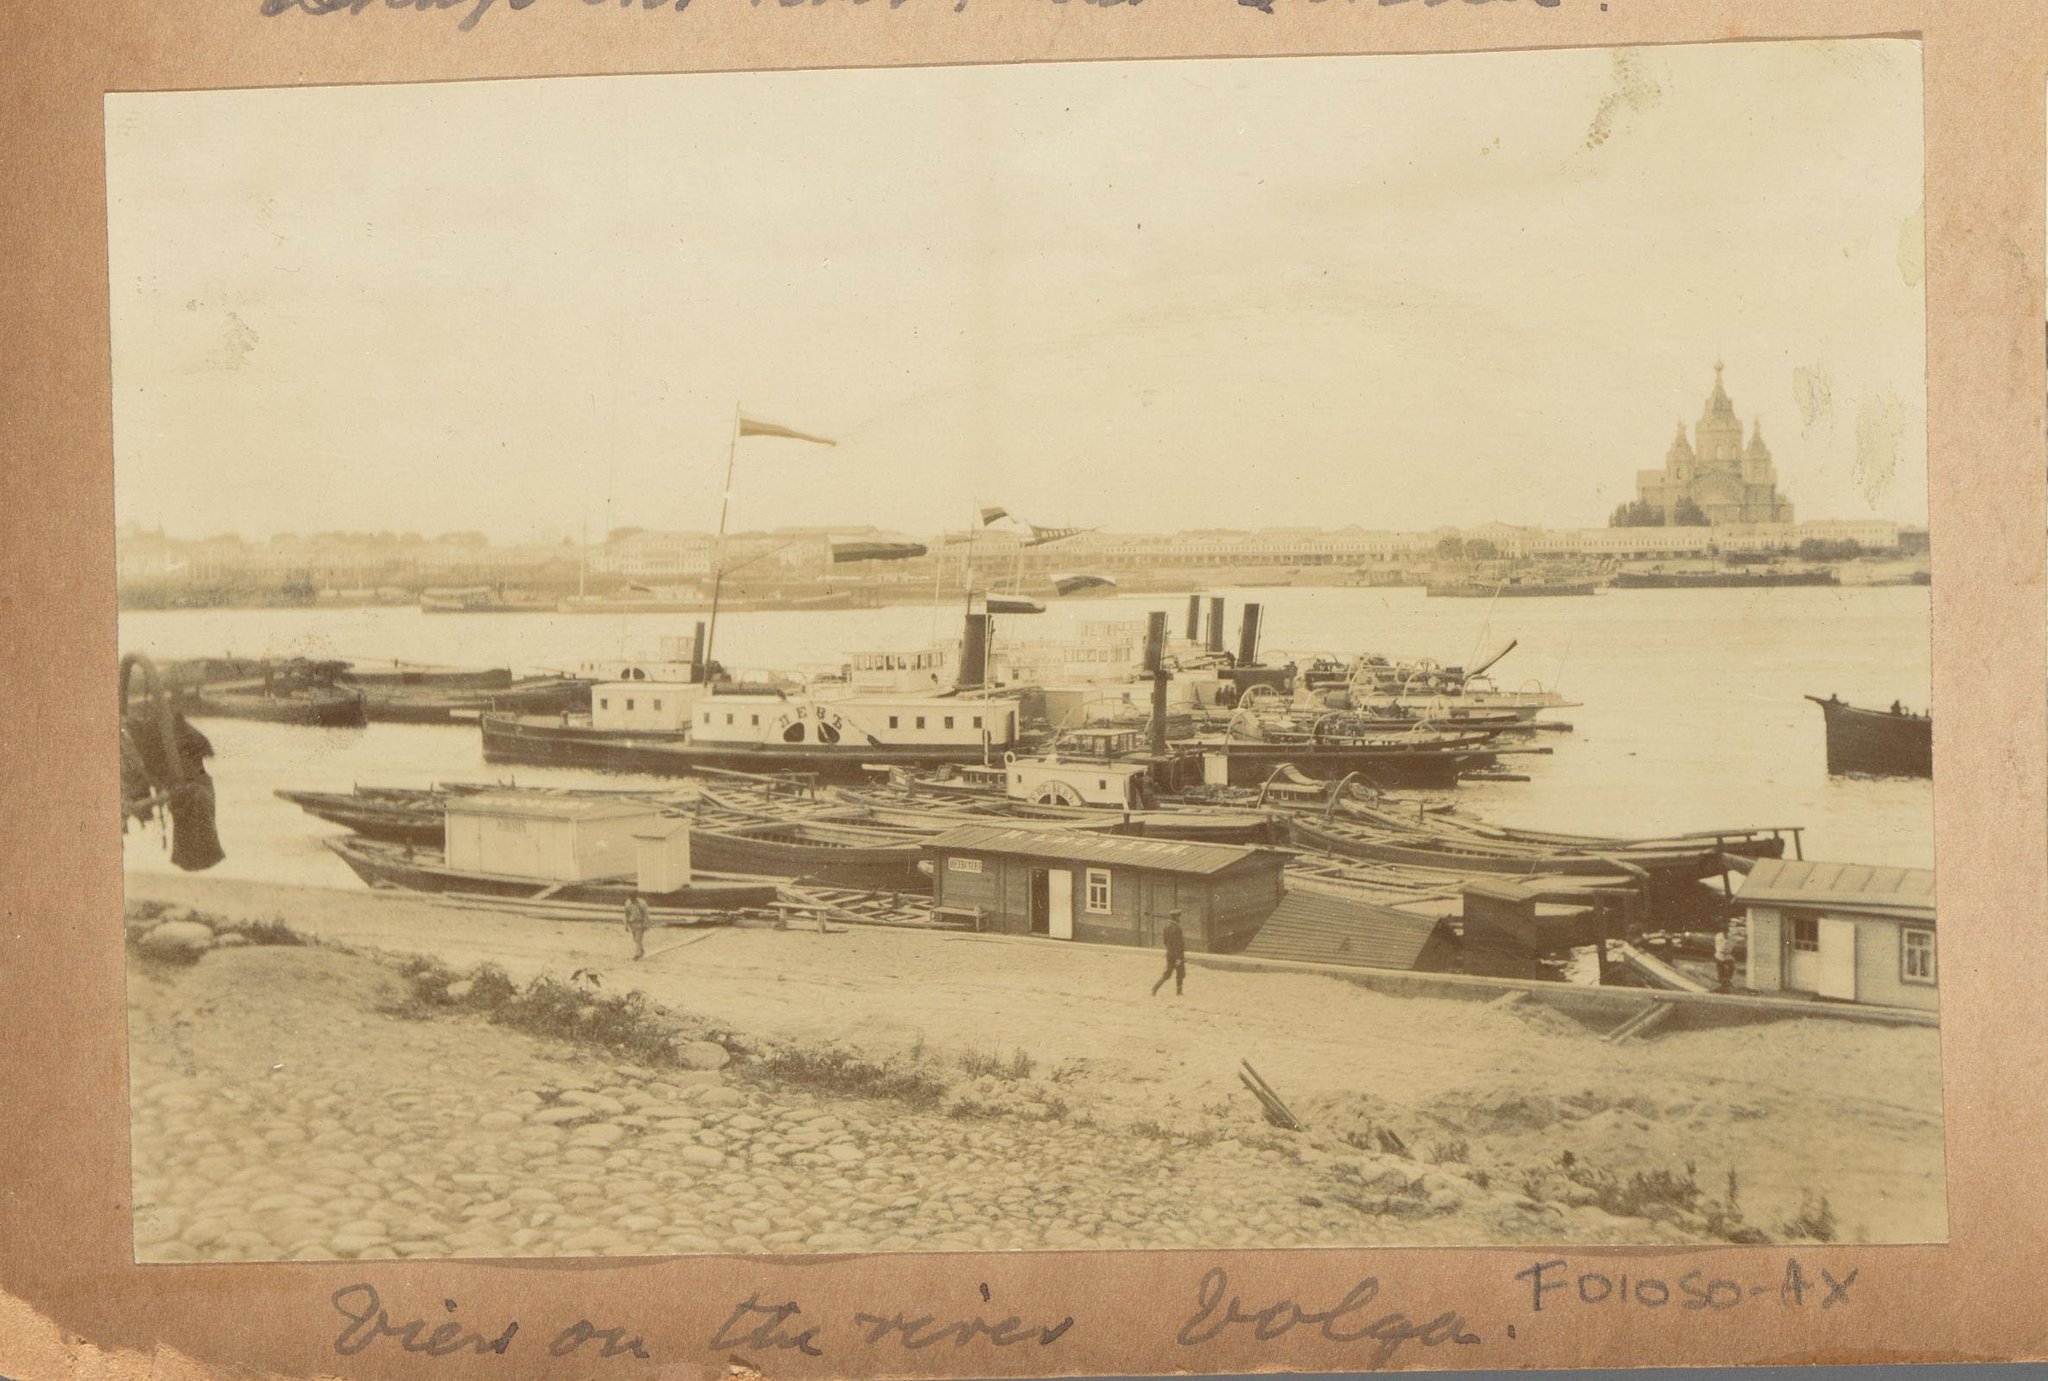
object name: photograph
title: Gezicht op boten op de Wolga met aan de horizon een kerk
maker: joseph cheetham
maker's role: engineer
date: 1903-1904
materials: photographic support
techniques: gelatin silver print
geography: russia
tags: river bank, church (exterior), steamship, motorship, russia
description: Onderdeel van Fotoalbum van de Engelse familie Cheetham met opnames van hun verblijf in Rusland.